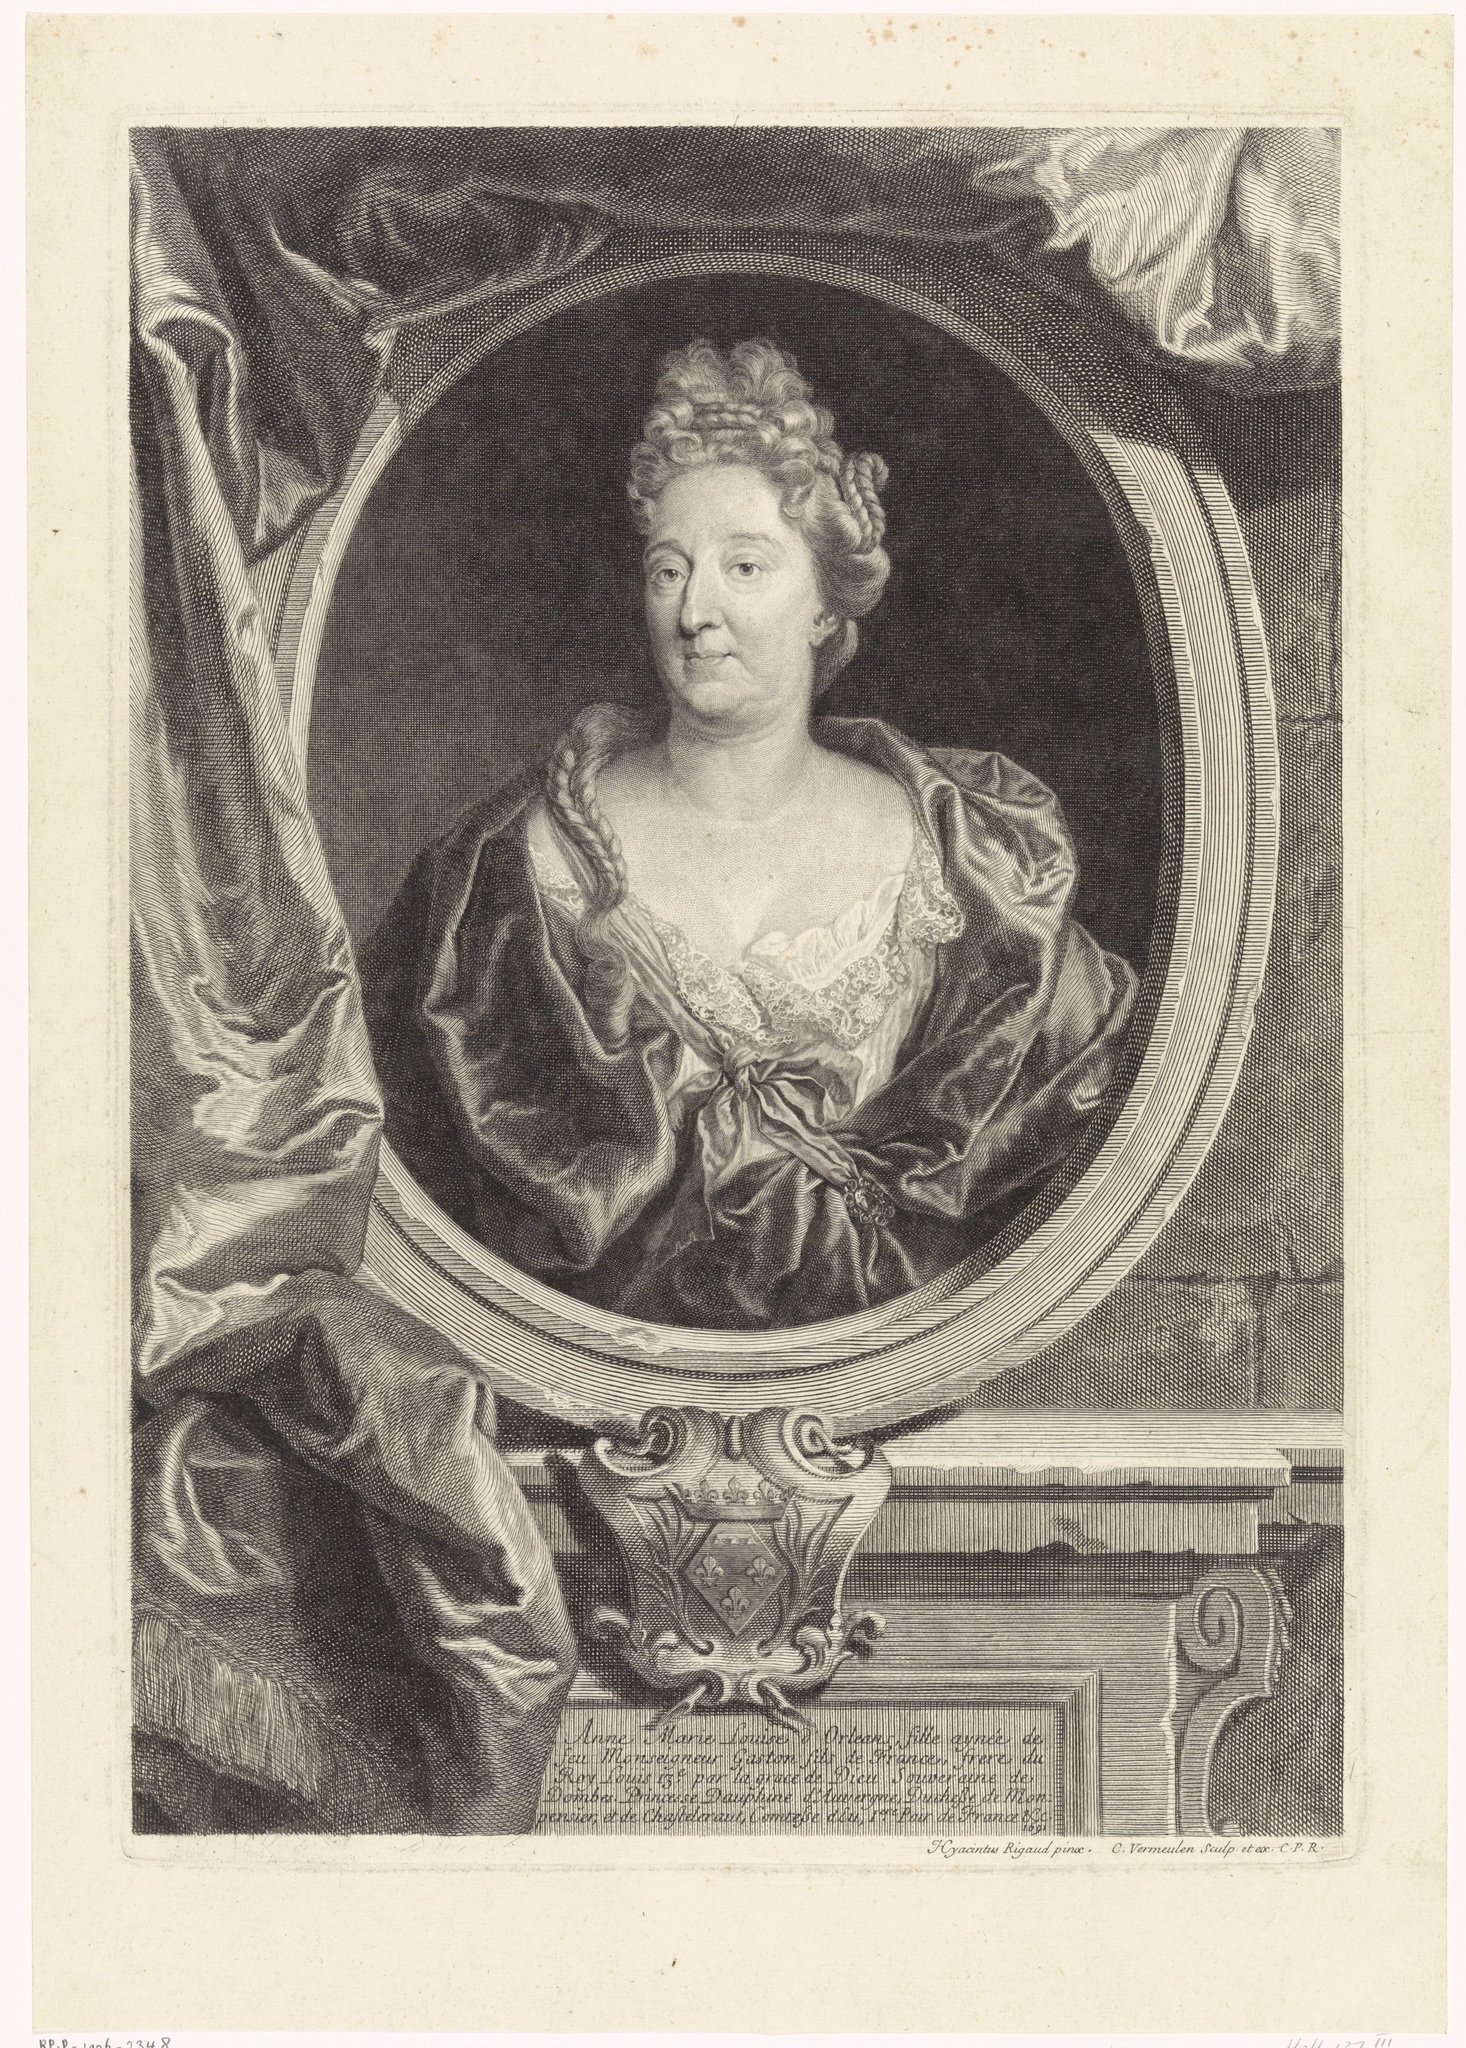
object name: print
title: Portret van Marguerite Louise van Orleans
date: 1691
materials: paper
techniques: engraving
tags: paris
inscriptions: collector's mark: Lugt 2228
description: Portret van Marguerite Louise van Orleans, oudste dochter van Gaston van Orléans, de broer van Lodewijk XIII, koning van Frankrijk.